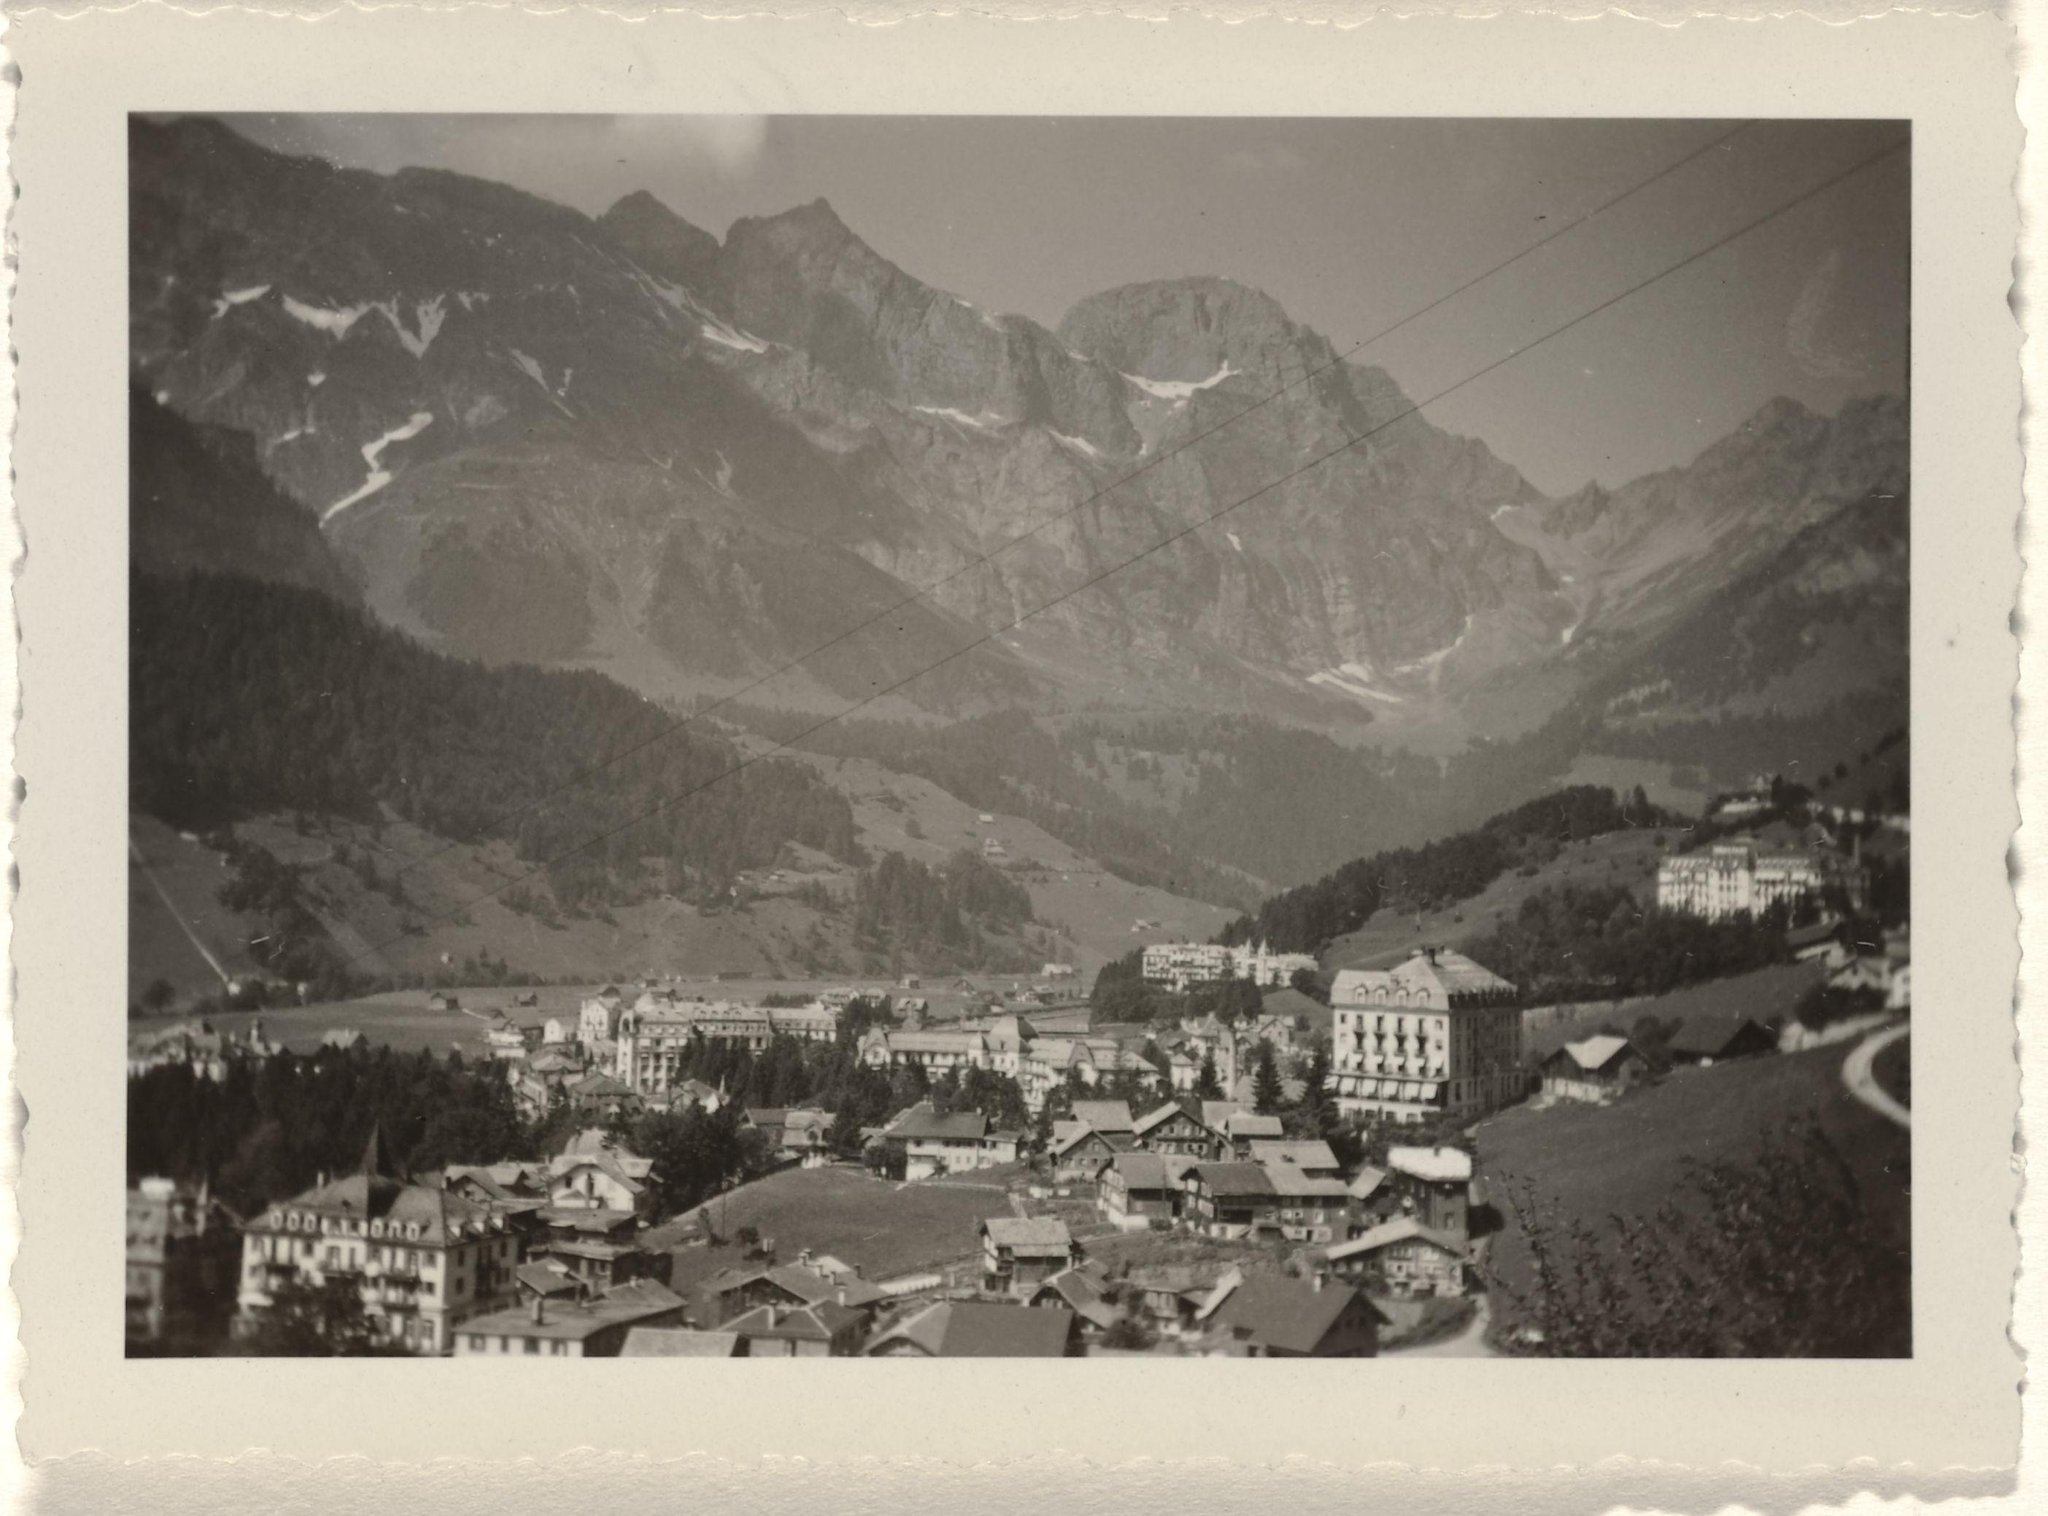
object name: photograph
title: Zwitserse plaats Engelberg vanuit het oosten, met bergen op de achtergrond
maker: Anonymous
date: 1908-1935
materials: photographic support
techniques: gelatin silver print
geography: switzerland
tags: trübsee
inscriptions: date: ‘Aug. 1935 Engelberg (Schweiz) von Osten’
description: Zicht op de Zwitserse plaats Engelberg vanuit het oosten, met bergen op de achtergrond.